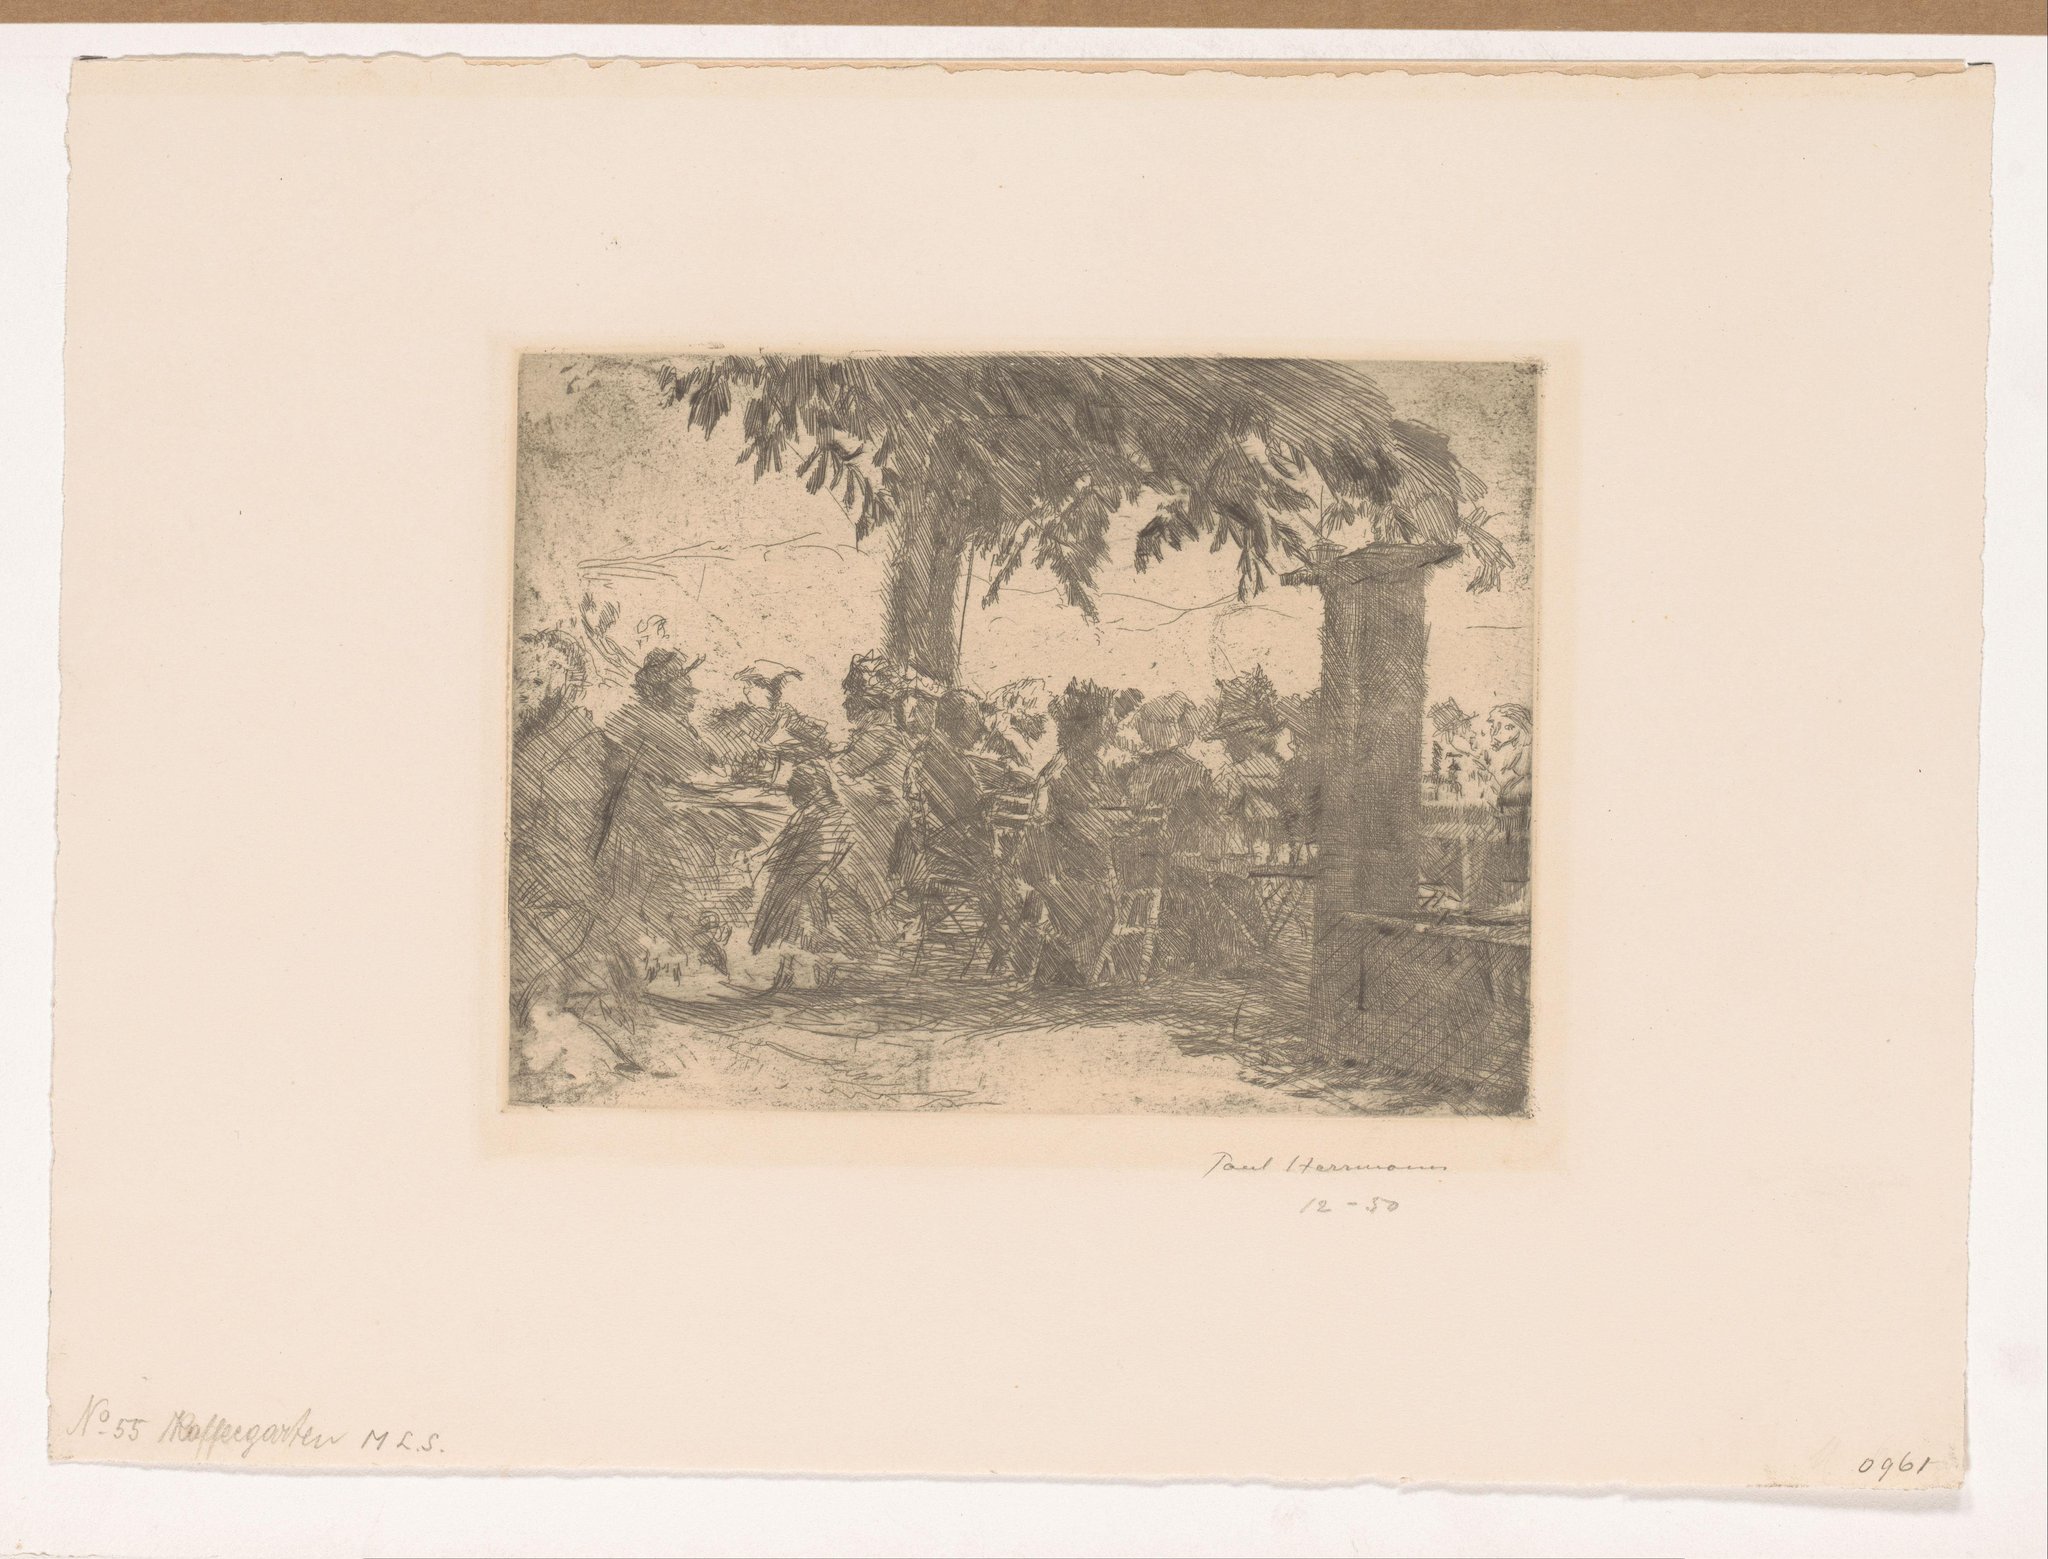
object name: print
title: Kaffeegarten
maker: paul herrmann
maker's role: painter, print maker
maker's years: 1864-1944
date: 1911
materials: paper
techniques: drypoint, etching, intaglio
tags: pavement, terrace in front of inn or restaurant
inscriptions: collector's mark: Lugt 2760, collector's mark: Lugt 2228